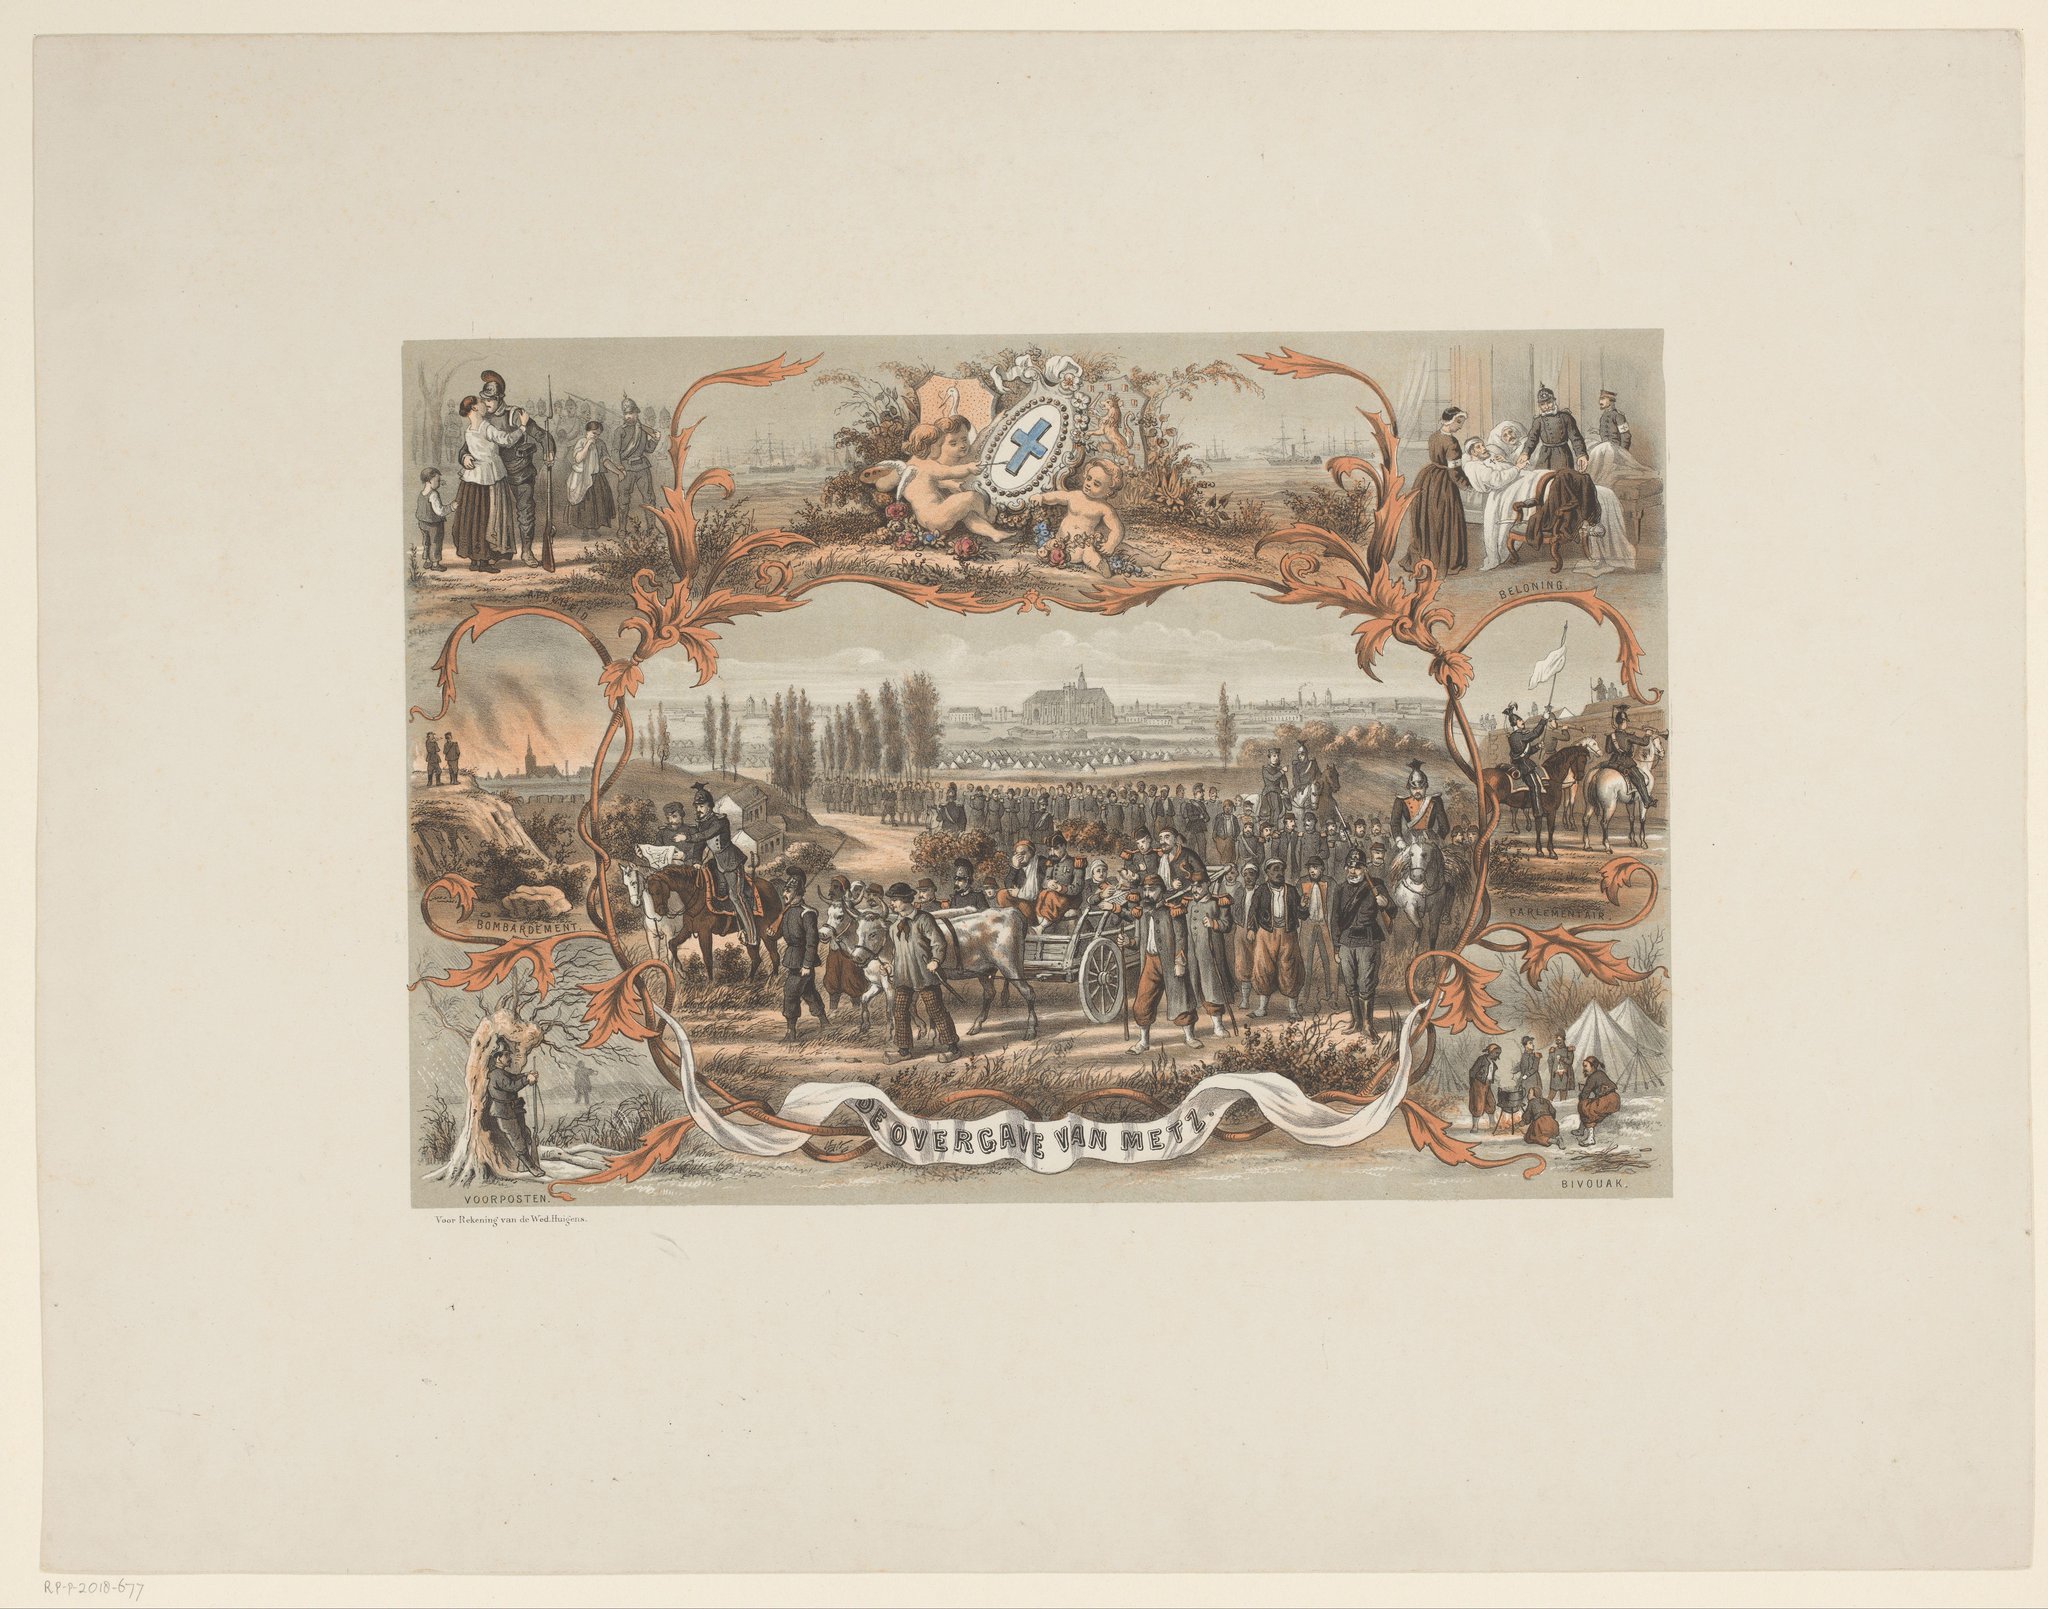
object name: print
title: De overgave van Metz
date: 1870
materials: paper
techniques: hand coloring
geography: netherlands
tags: capture of city (after the siege)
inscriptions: collector's mark: Lugt 2228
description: De overgave van de Franse stad Metz op 27 oktober 1870 aan het Pruisisch-Duitse leger. Centraal het wegtrekken van de verslagen Franse troepen, links en rechts kleinere scènes uit het strijdverloop. Bovenaan schildern putti een wapenschild.